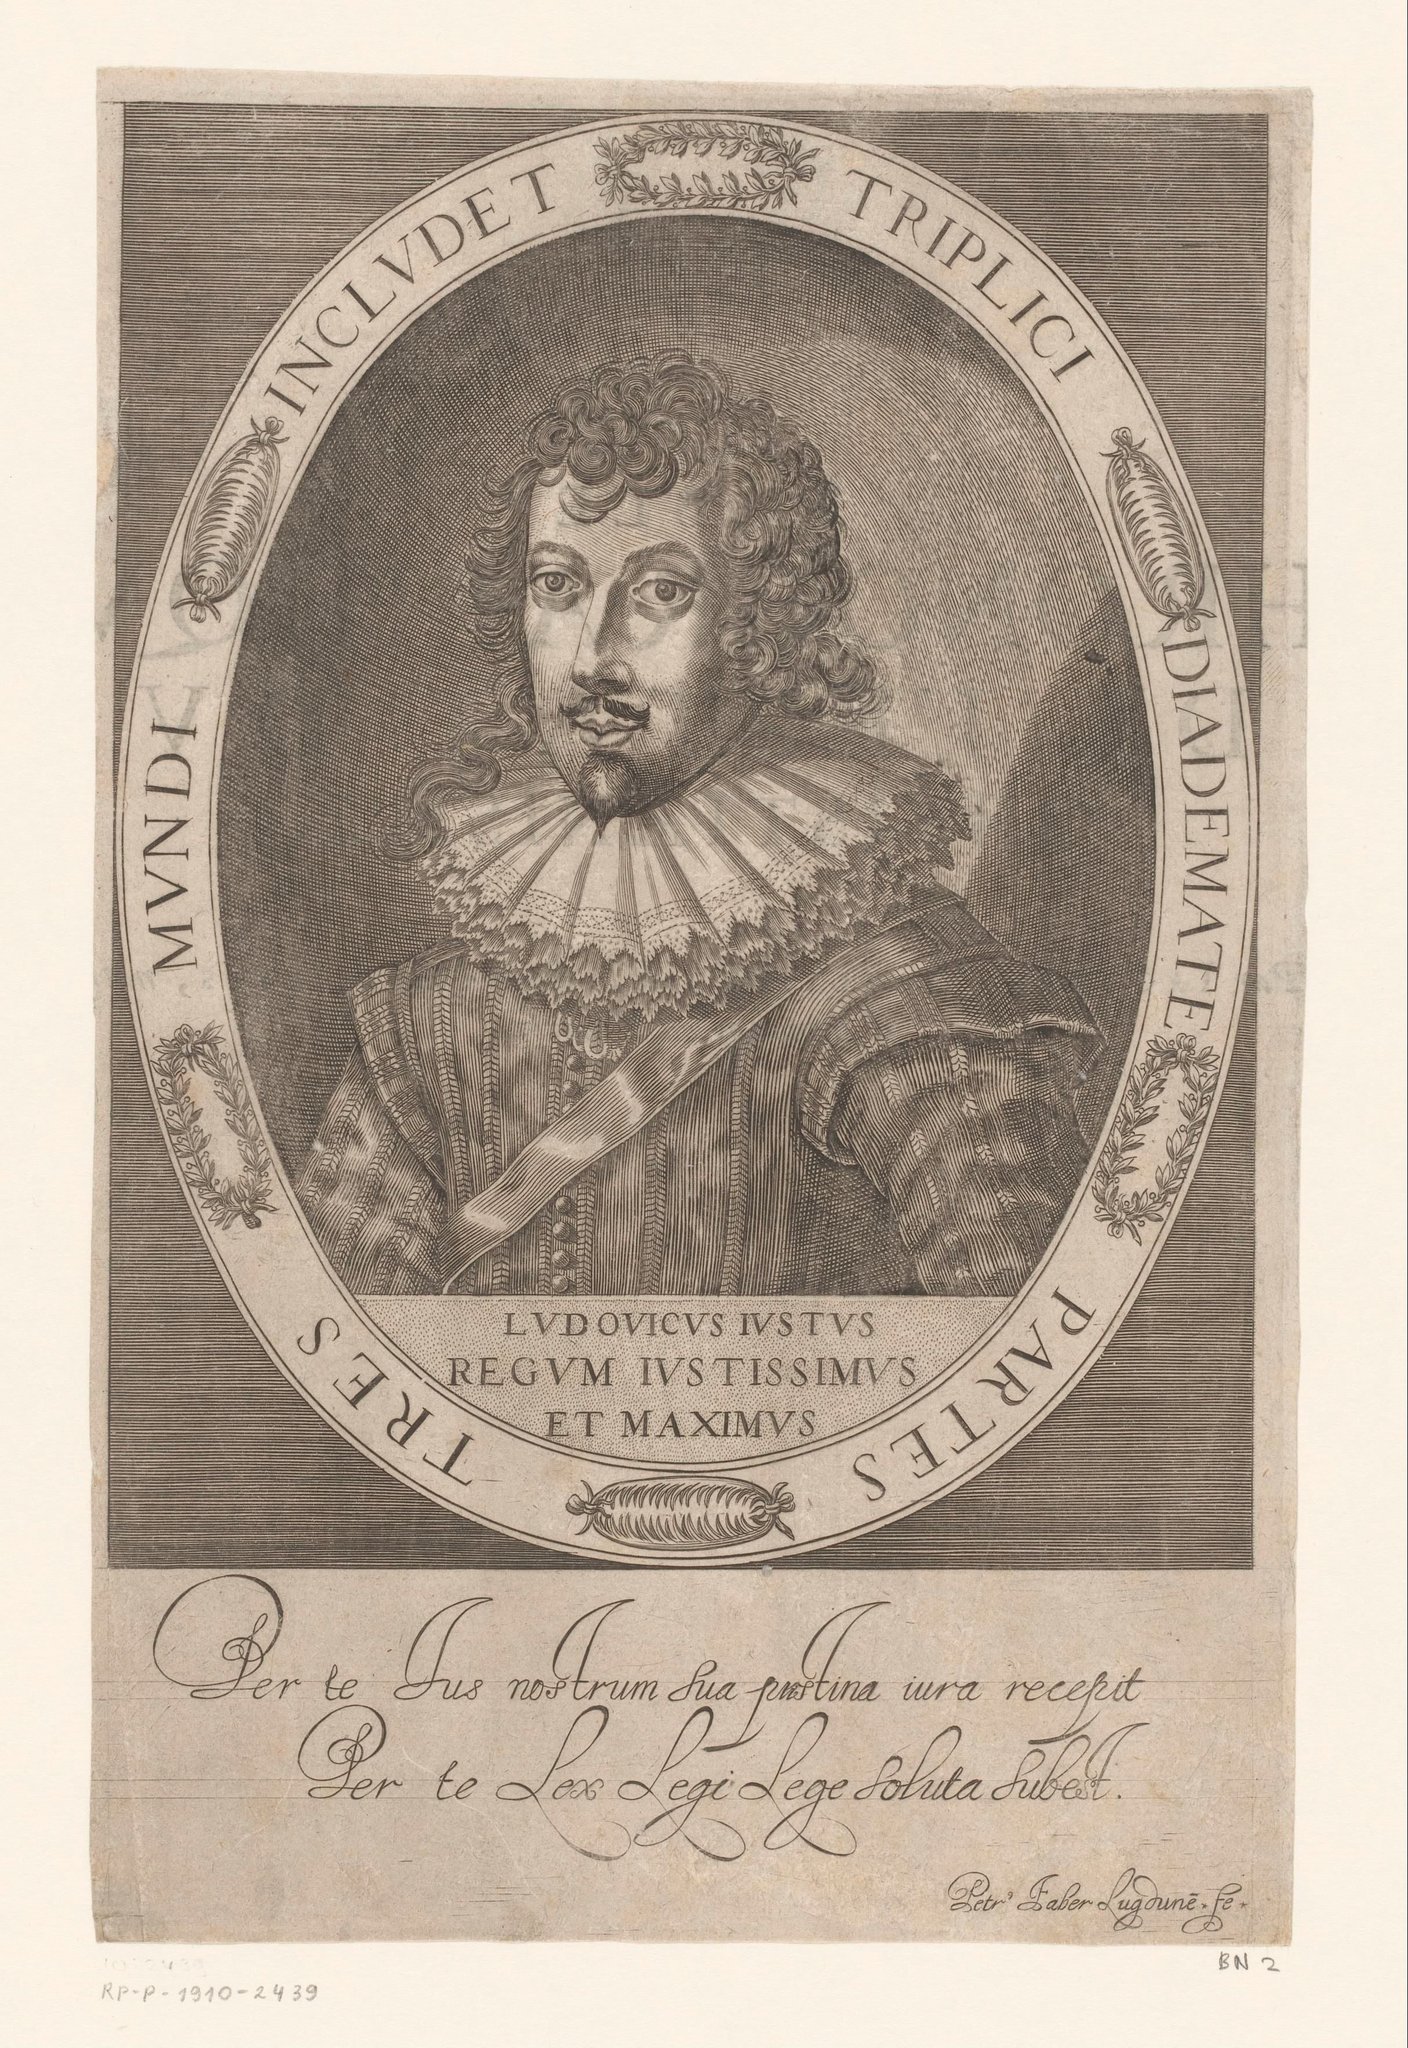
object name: book illustration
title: Ludovicus Justus regum justissimus et maximus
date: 1626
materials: paper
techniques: engraving, letterpress printing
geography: lyon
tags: lodewijk xiii (koning van frankrijk), ornament ~ medallion, historical persons, ruler, sovereign, lock of hair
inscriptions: collector's mark: Lugt 2228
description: Prent uit: Gaultier, Jacques. Table chronographique de l'estat du Christianisme. S.l.: Pierre Rigaud, 1626.